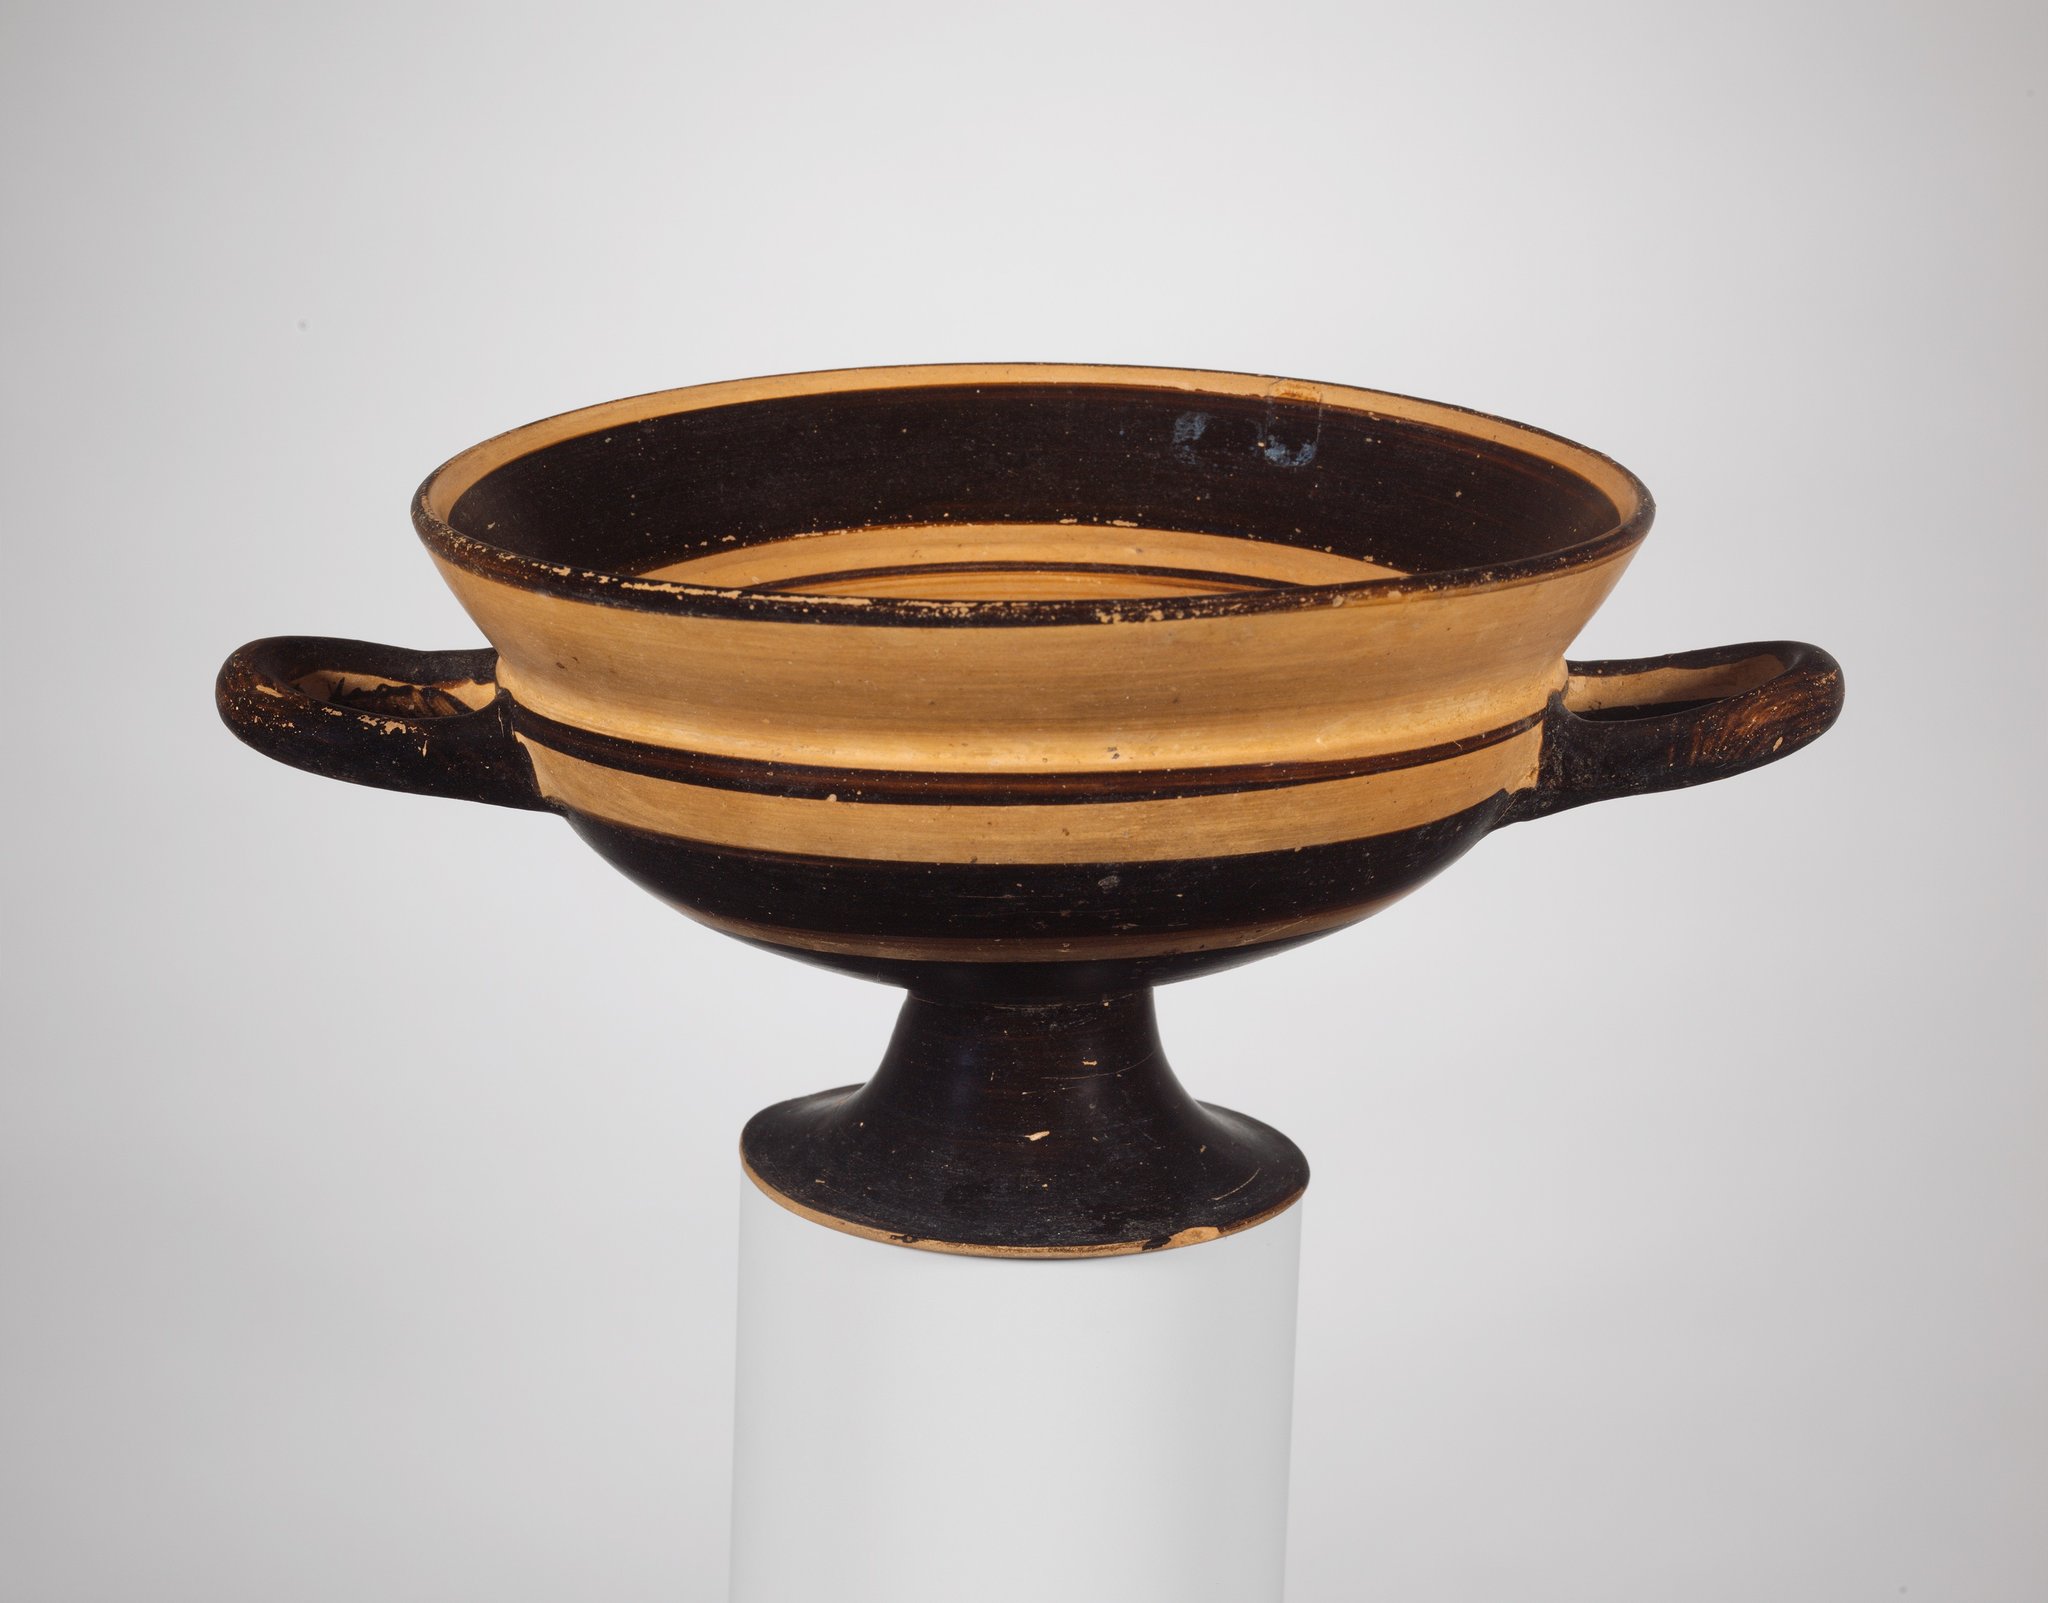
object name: kylix, lip cup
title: Terracotta kylix (drinking cup)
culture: east greek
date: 600-501 BCE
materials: terracotta